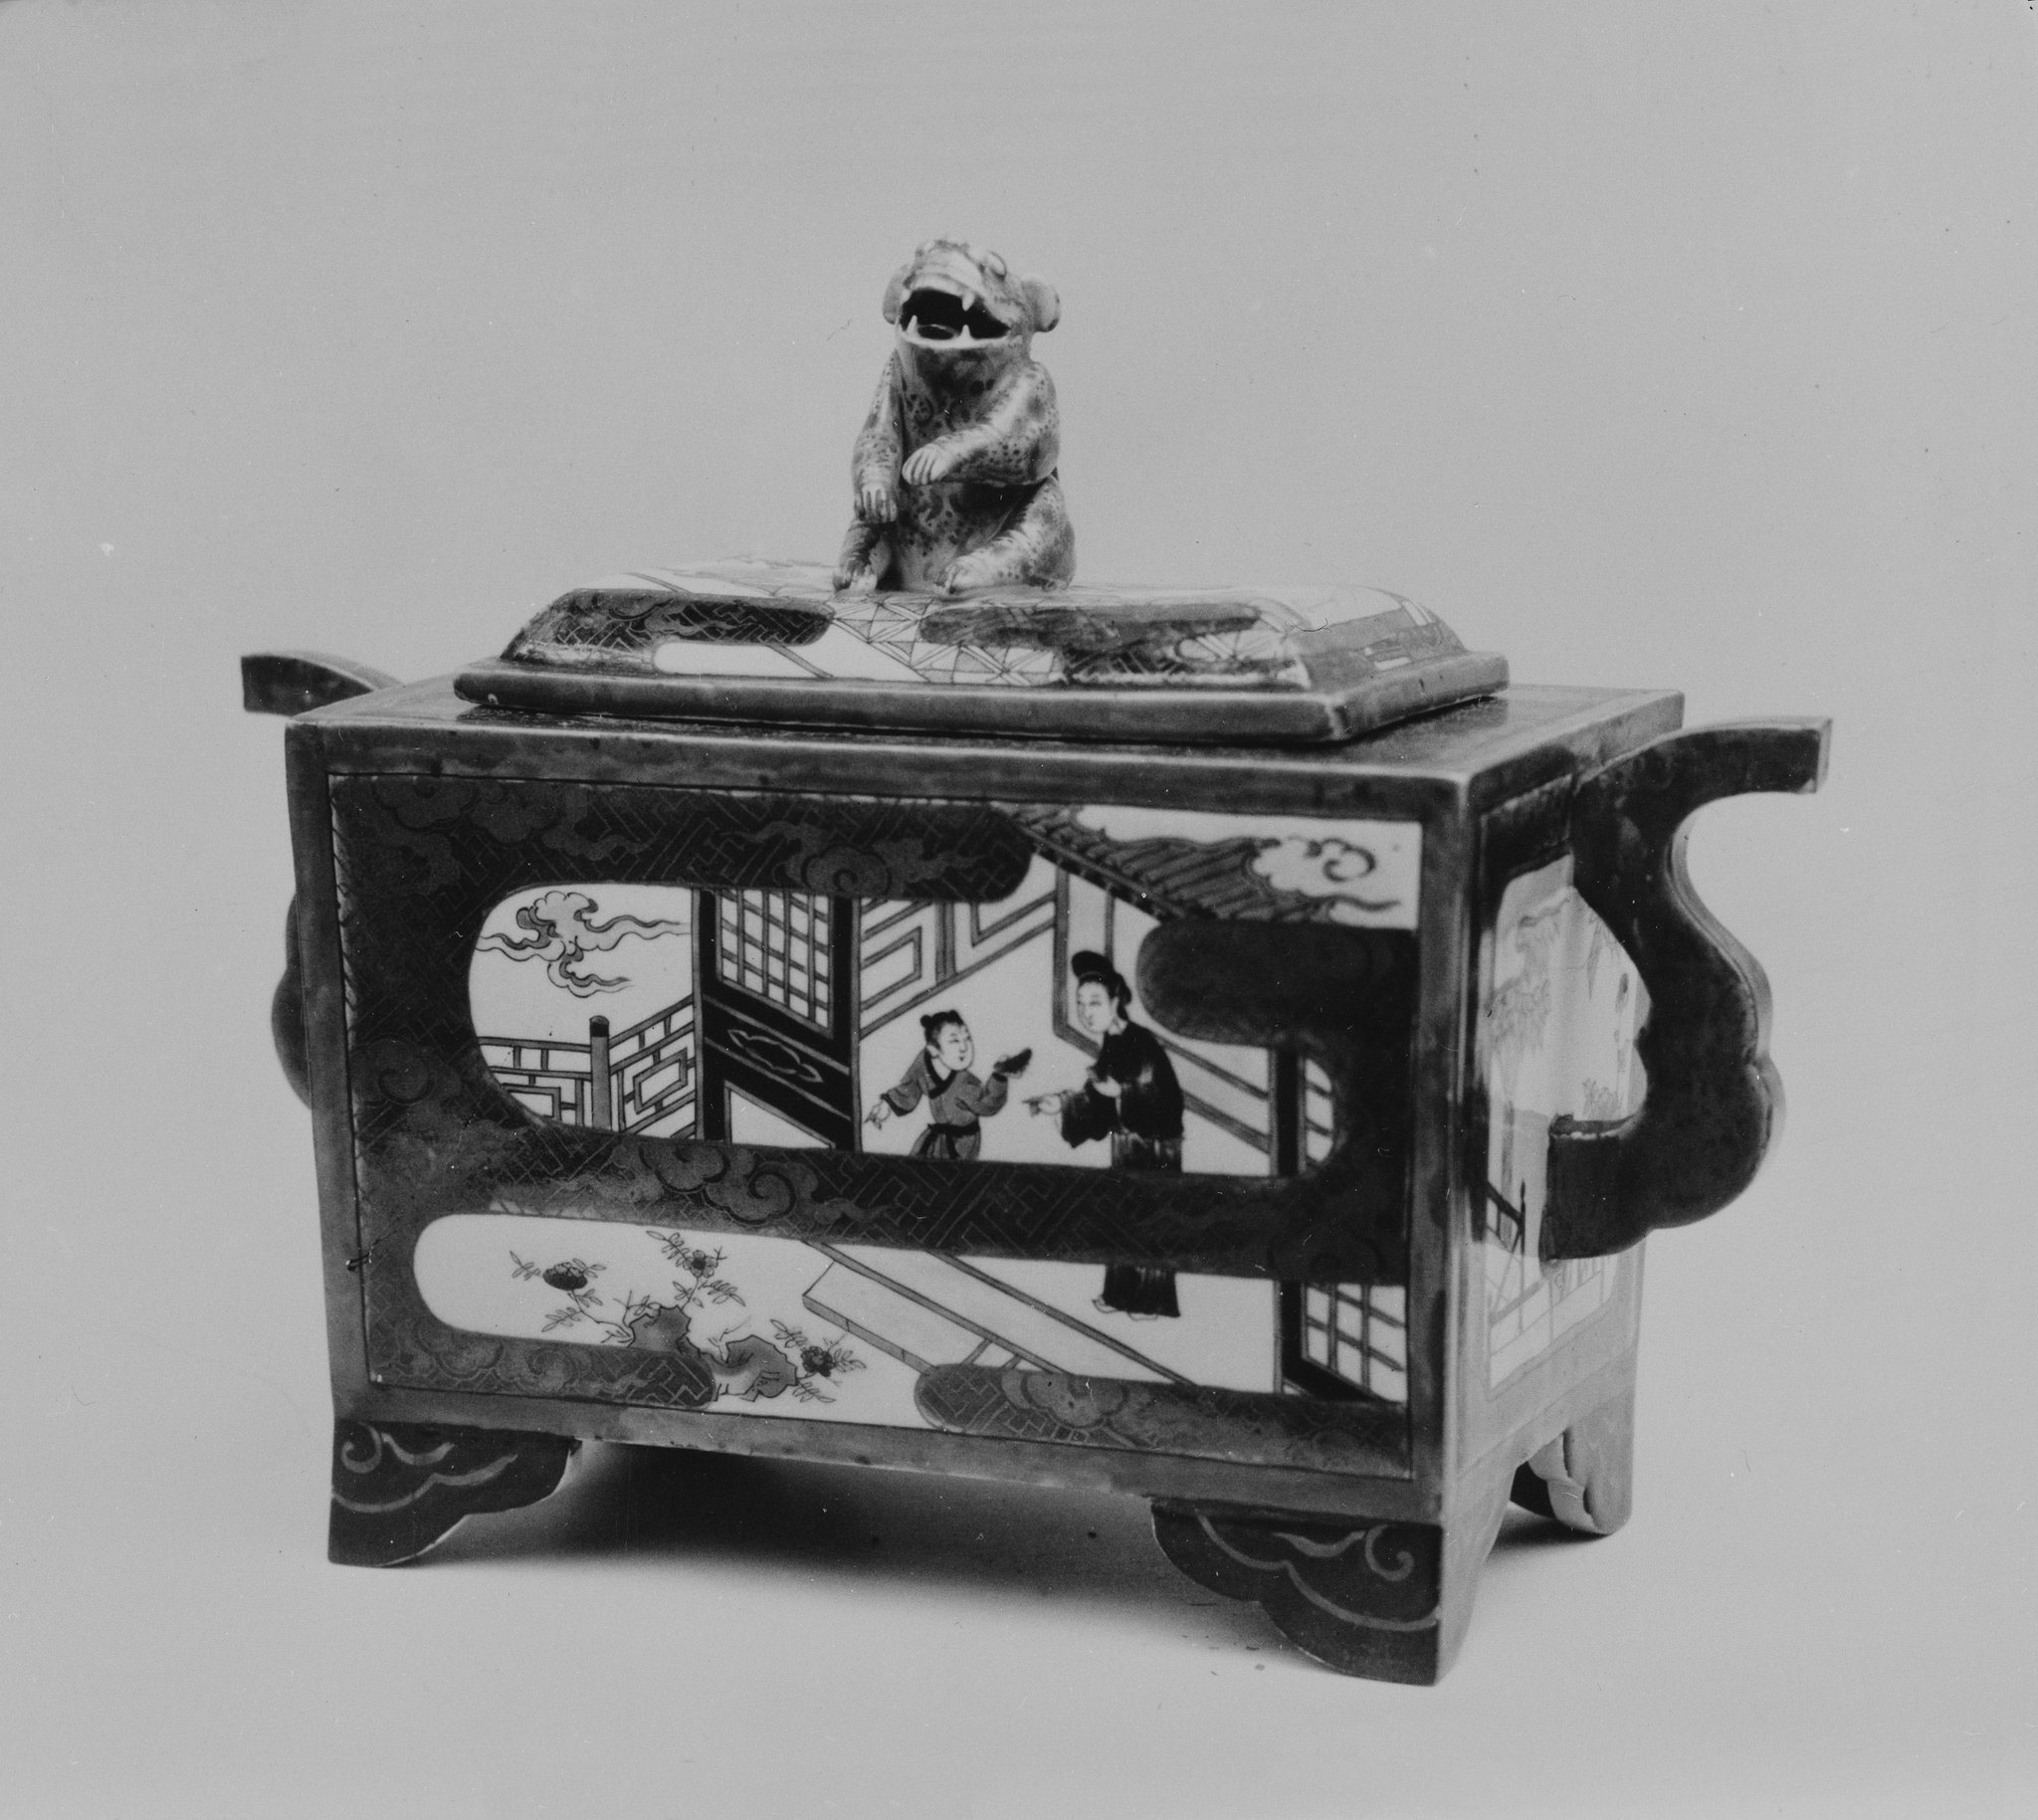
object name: censer with cover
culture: japanese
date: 1750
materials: enamel, porcelain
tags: human figures,animals,censers